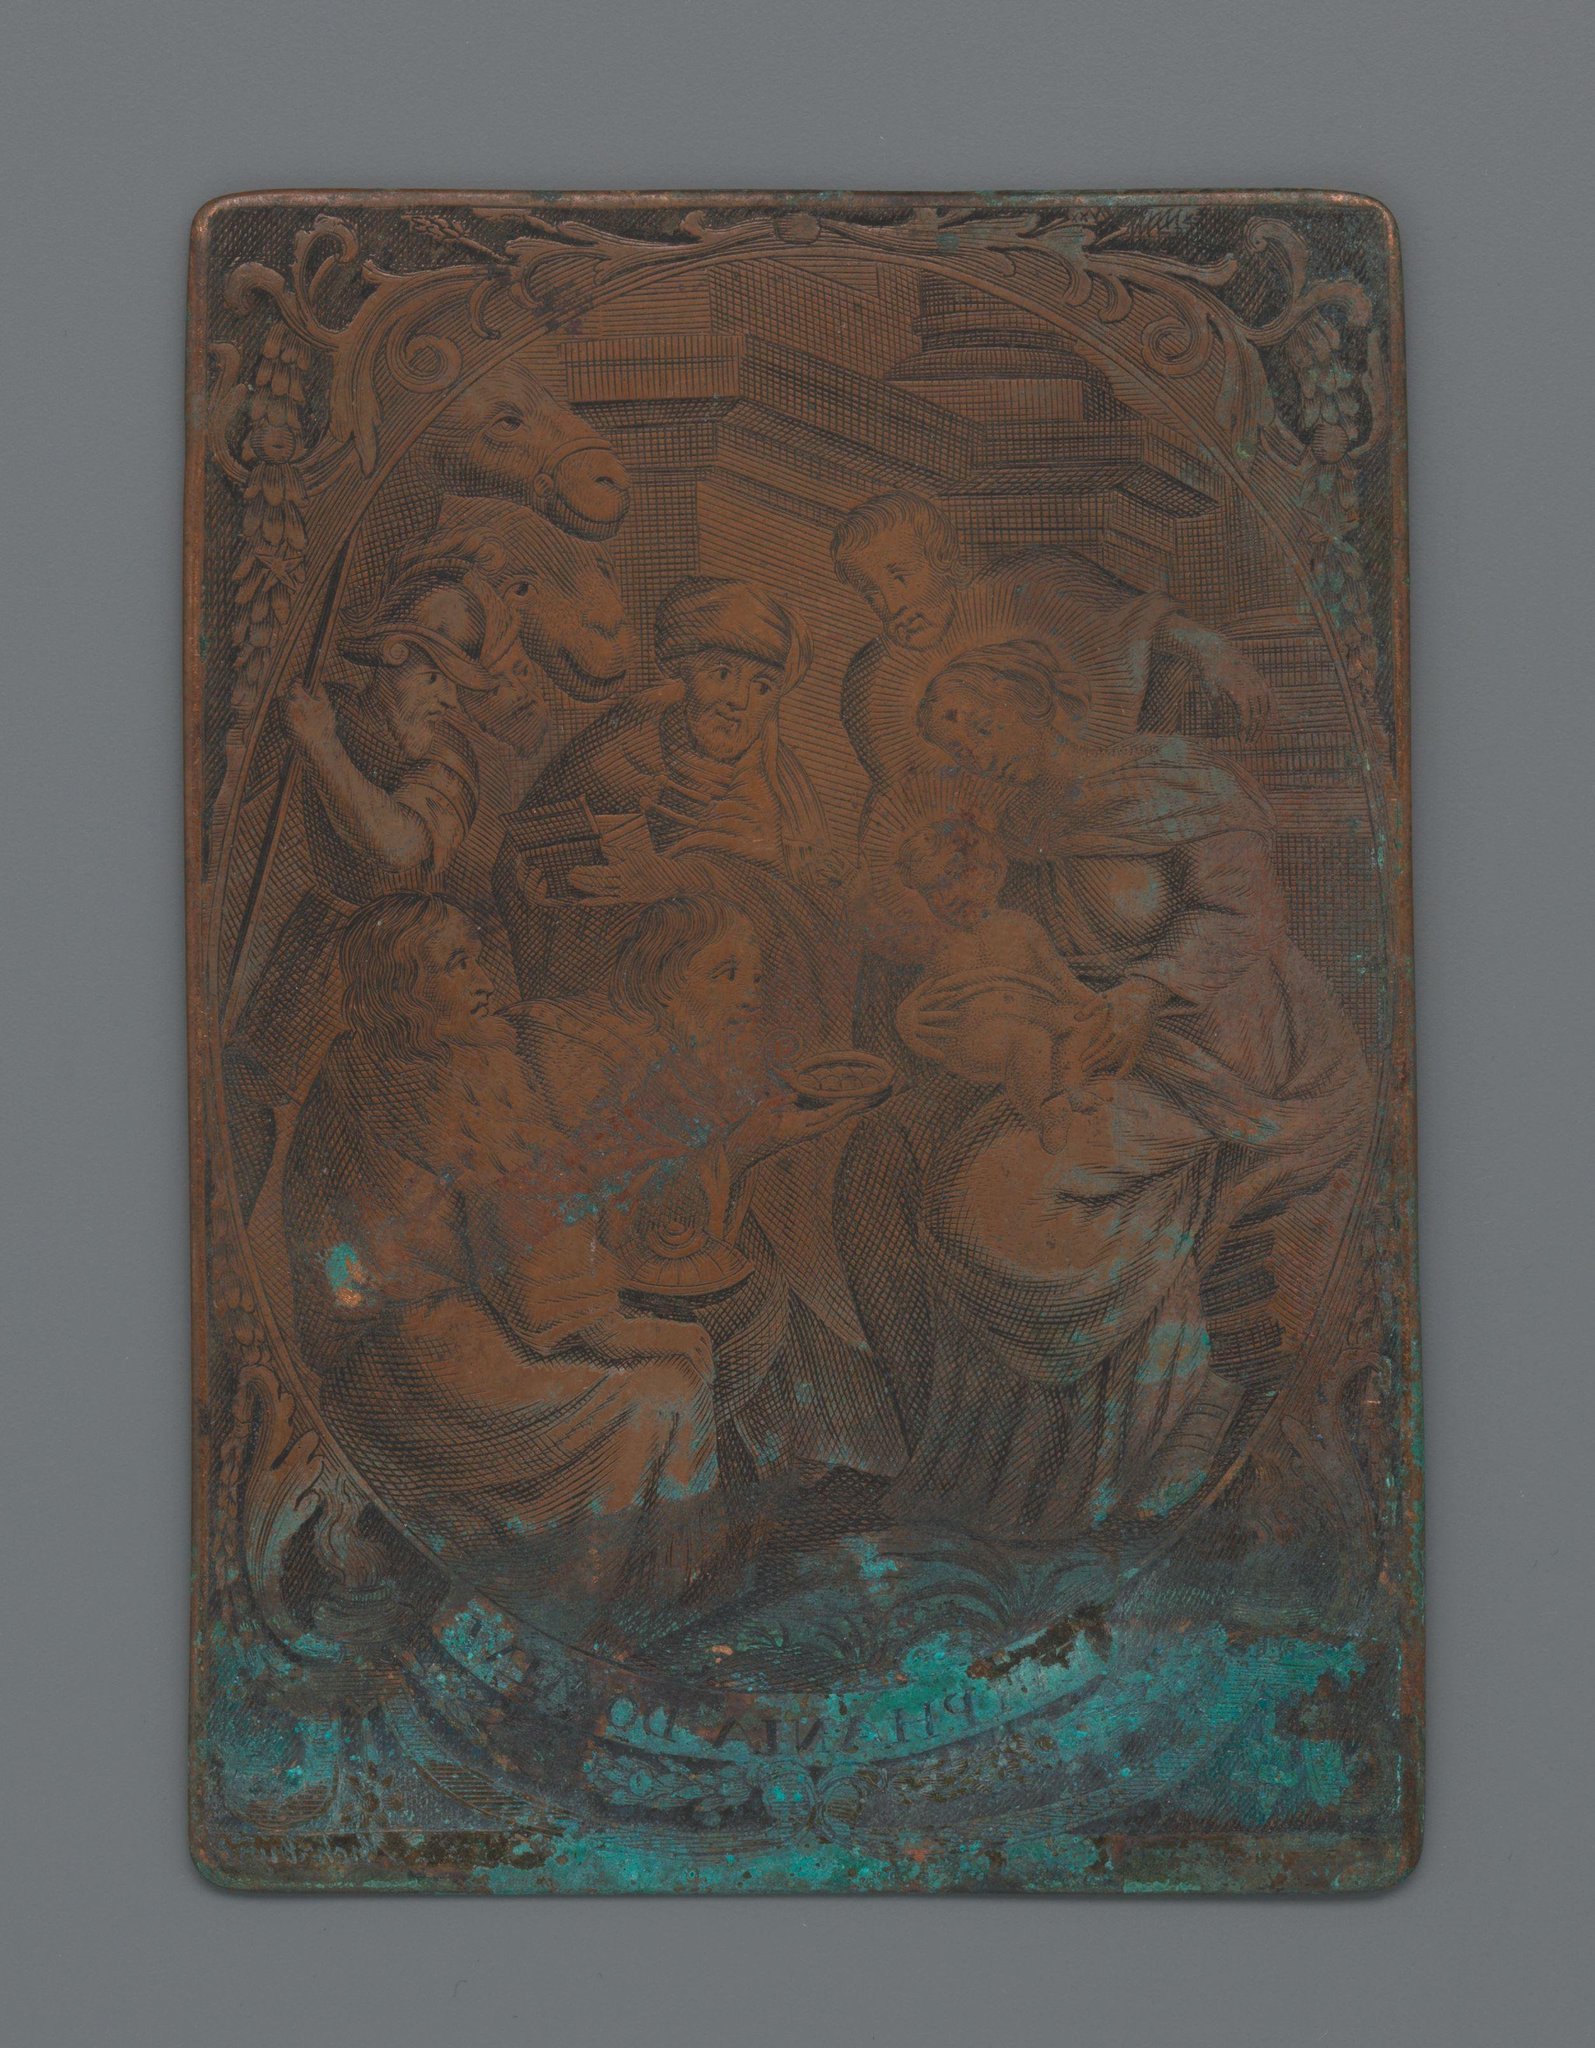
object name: copper plate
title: Koperplaat met de Aanbidding door de Koningen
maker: Anonymous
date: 1690-1739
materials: copper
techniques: engraving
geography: antwerp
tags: adoration of the kings: the wise men present their gifts to the christ-child (gold, frankincense and myrrh)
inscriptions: signature: ‘Mich.bunel’, inscription: ‘Epiphania domini’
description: De platen (RP-D-2014-9-1 t/m 35) zijn vrijwel allemaal vervaardigd door anonieme graveurs werkend voor de Antwerpse uitgevers Cornelis Galle, Frans Huberti (Huybrechts), Theodor van Merlen II en Michel Bunel. Vermoedelijk zijn ze uiteindelijk beland in één fonds, wellicht dat van Michel Bunel (1670-1739) en warden sindsdien bij elkaar bewaard. Afwijkend is de grote prent van Henry Verbruggen met een weergave van de Preekstoel uit de St. Gudule-kerk te Brussel. Twee prenten zijn verpakt in een oude afdruk van de prent, zoals te doen gebruikelijk in uitgeverijen (vergl. oude platen in Museum Plantijn Moretus, Antwerpen). Van 8 platen heeft de vorige eigenaar afdrukken laten maken op modern papier.